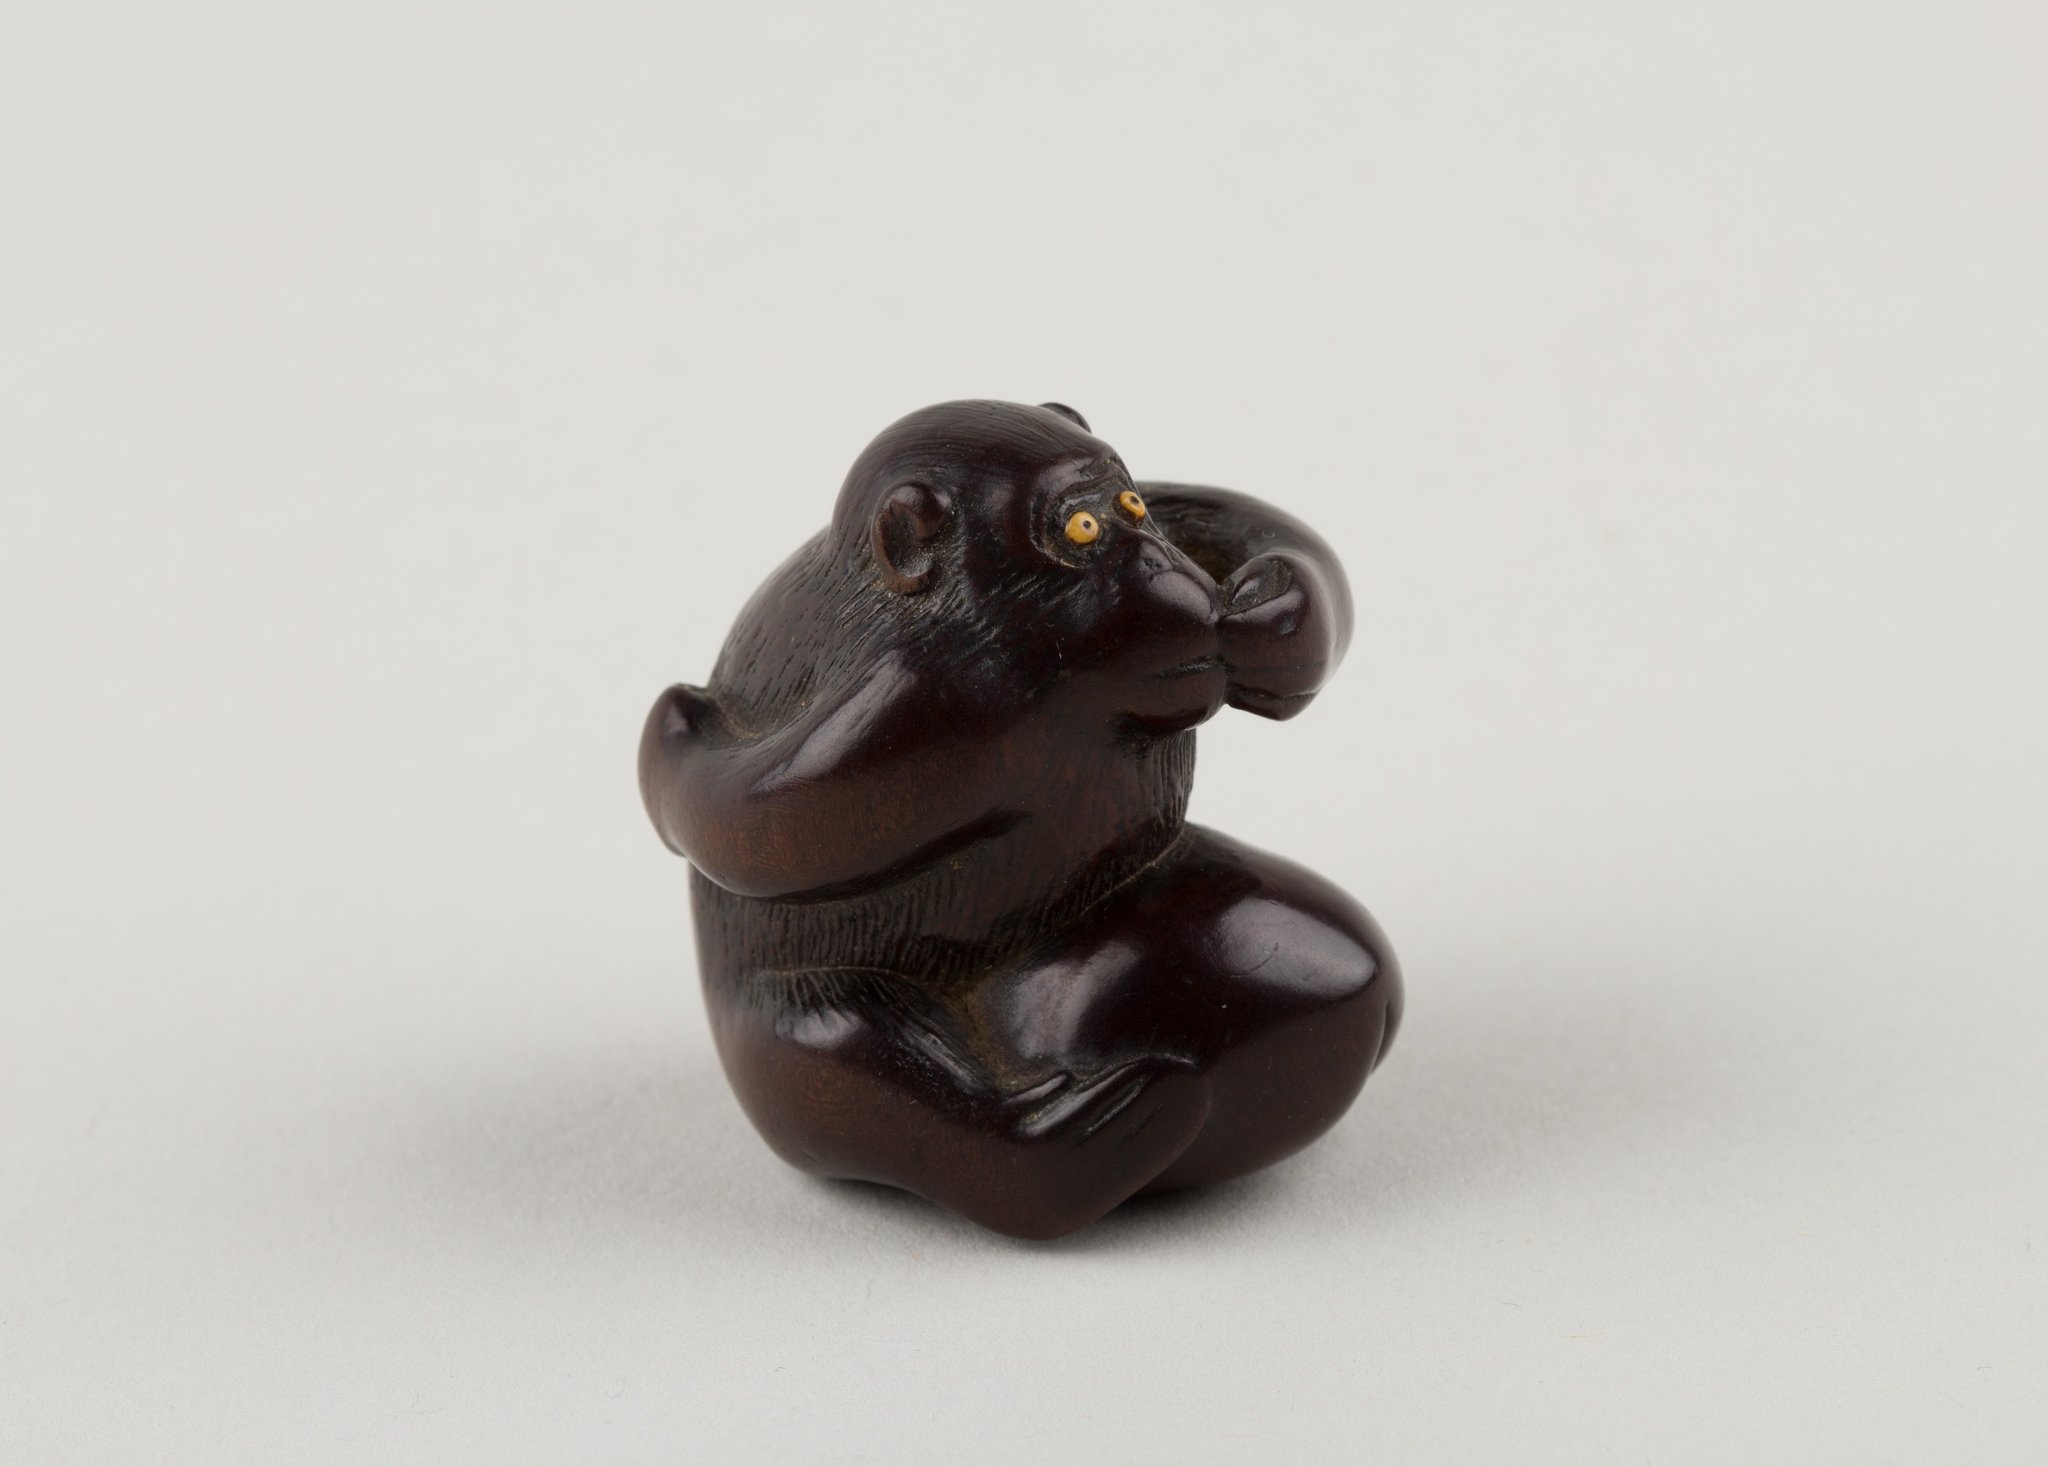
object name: netsuke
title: Netsuke of Monkey with One Hand over Mouth, the Other Behind His Back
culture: japanese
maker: miwa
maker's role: artist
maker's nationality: japanese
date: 1767-1833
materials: wood, ivory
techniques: inlay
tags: monkeys